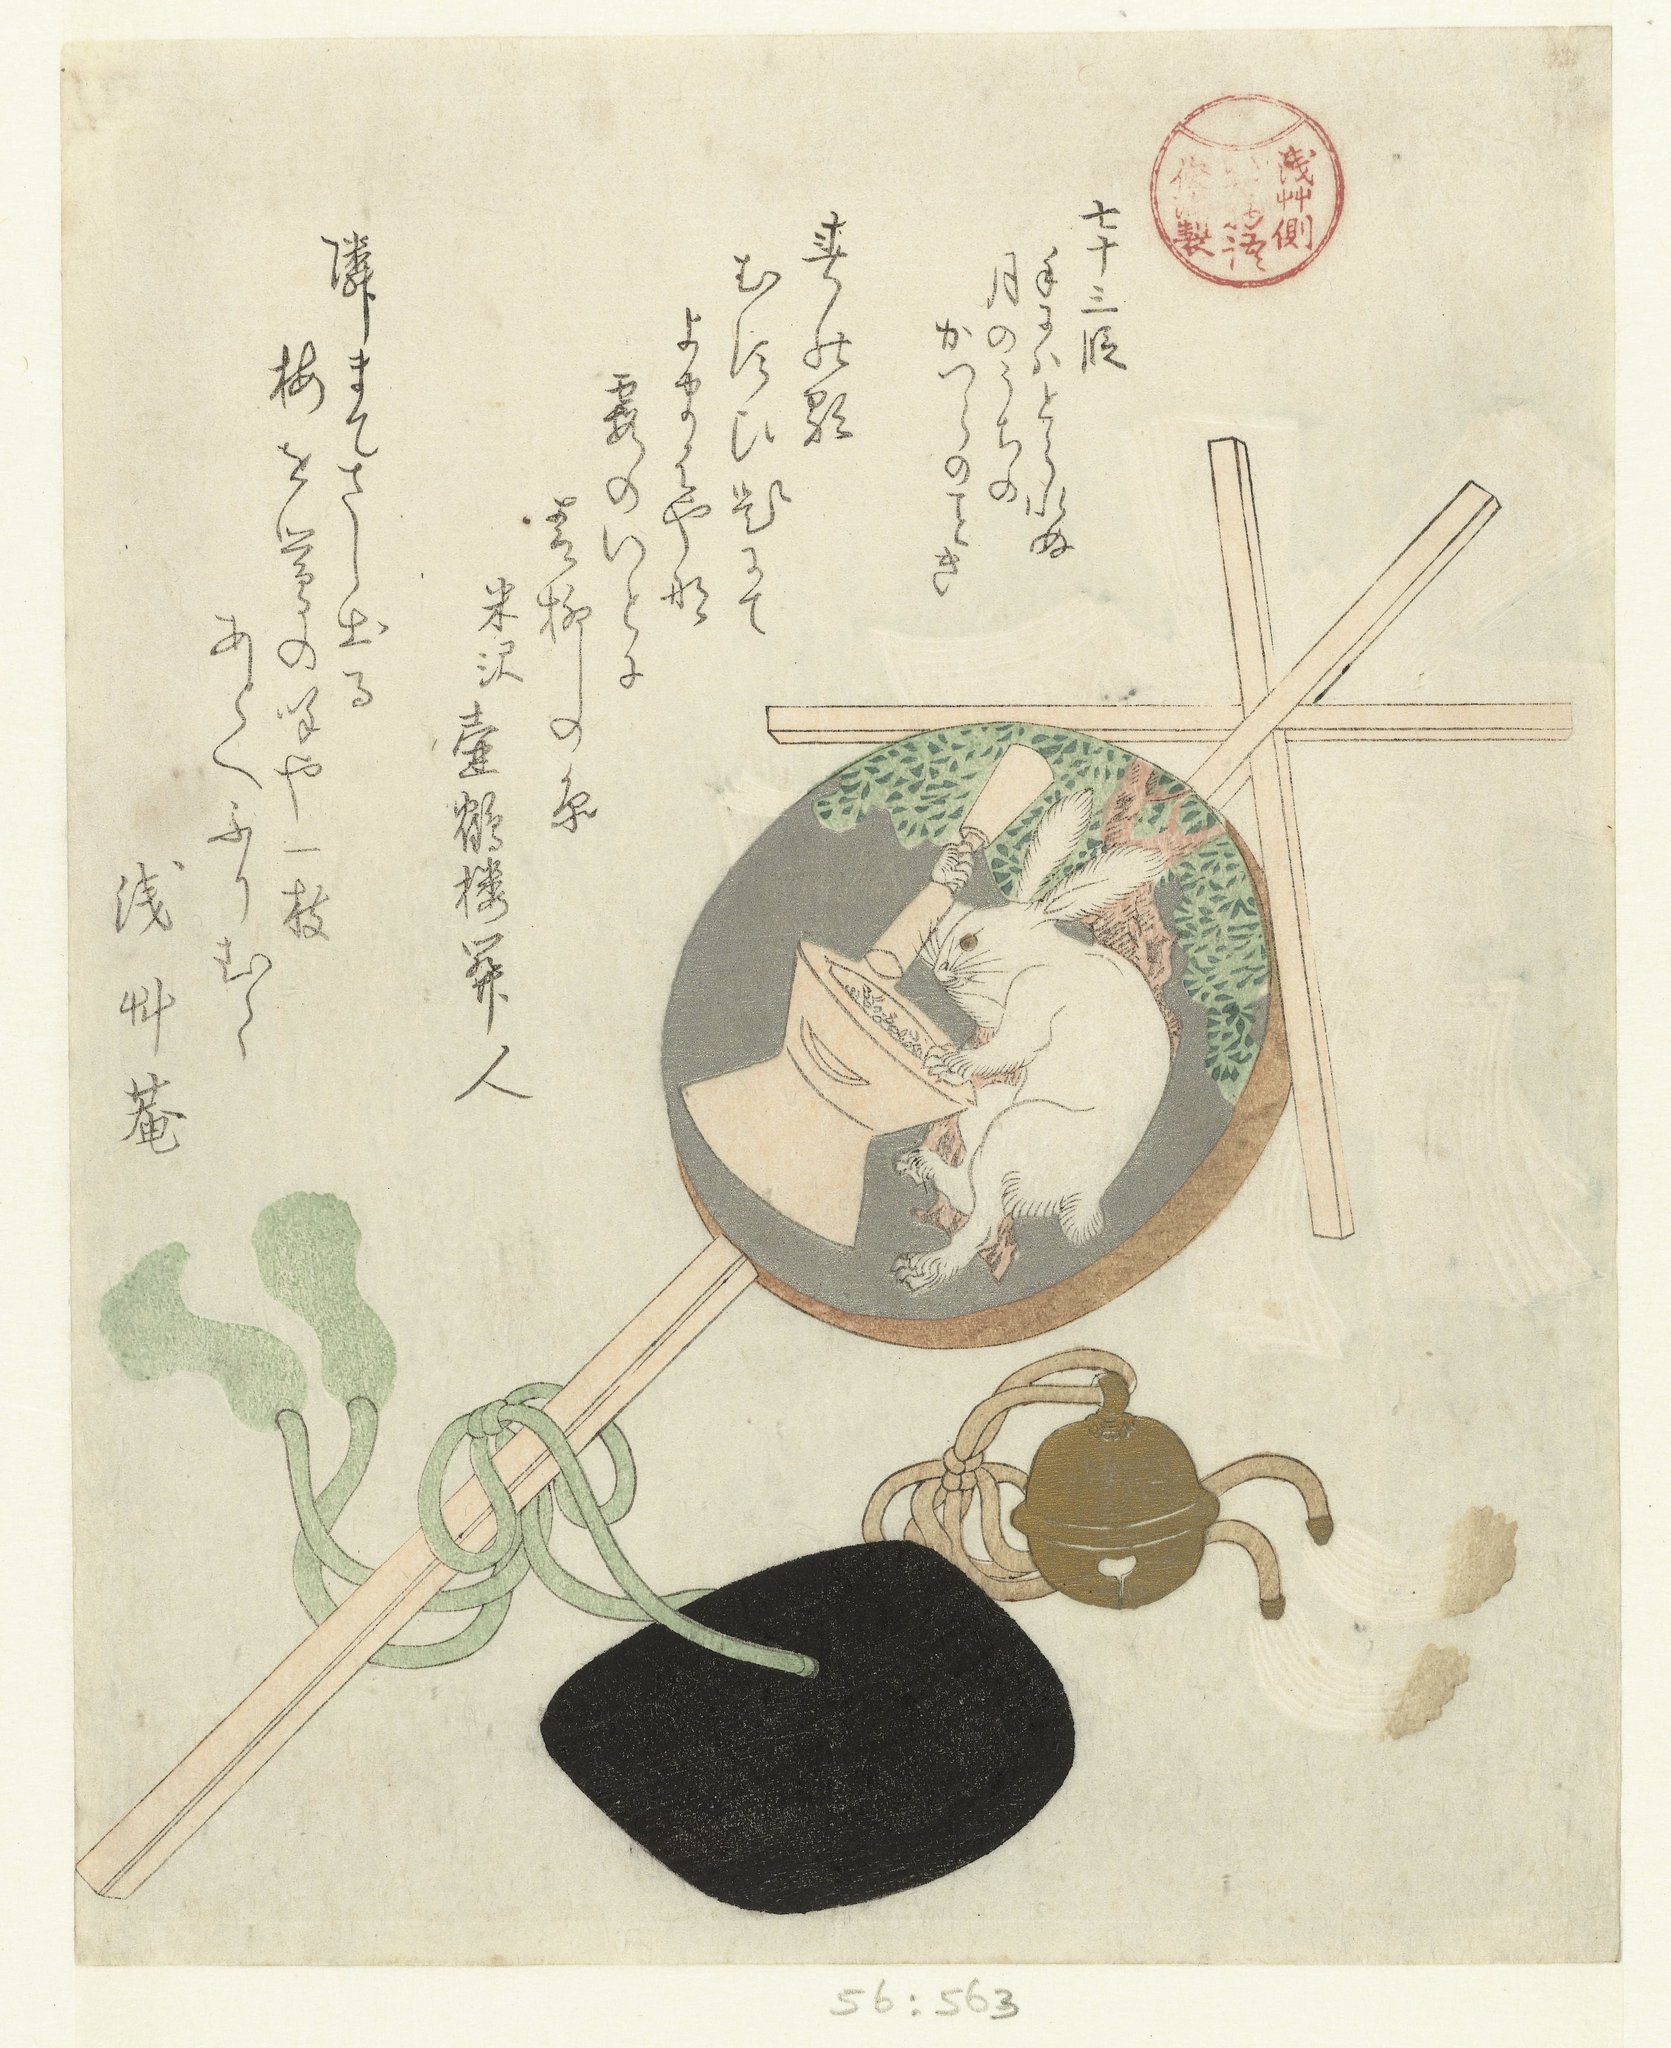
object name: surimono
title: Staff with Gohei and Moon Disc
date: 1812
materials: paper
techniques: blind stamped, woodcut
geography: japan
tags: rodents: hare, pestle and mortar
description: Een cirkelvormige schijf met een haas met een vijzel, bevestigd aan een houten staf met reepjes van papier (gohei). In de voorgrond een bronzen belletje met touw en een hofmuts (eboshi). De titel komt uit hoofdstuk 73 uit de Verhalen van Ise en zijn de gedachten van een man die langs het huis van een vrouw loopt. Hij kan haar geen bericht sturen, maar denkt: Ik kan je zien met mijn ogen maar mijn handen kunnen jou niet aanraken - je bent werkelijk net als de cassia in de maan. Met twee gedichten.